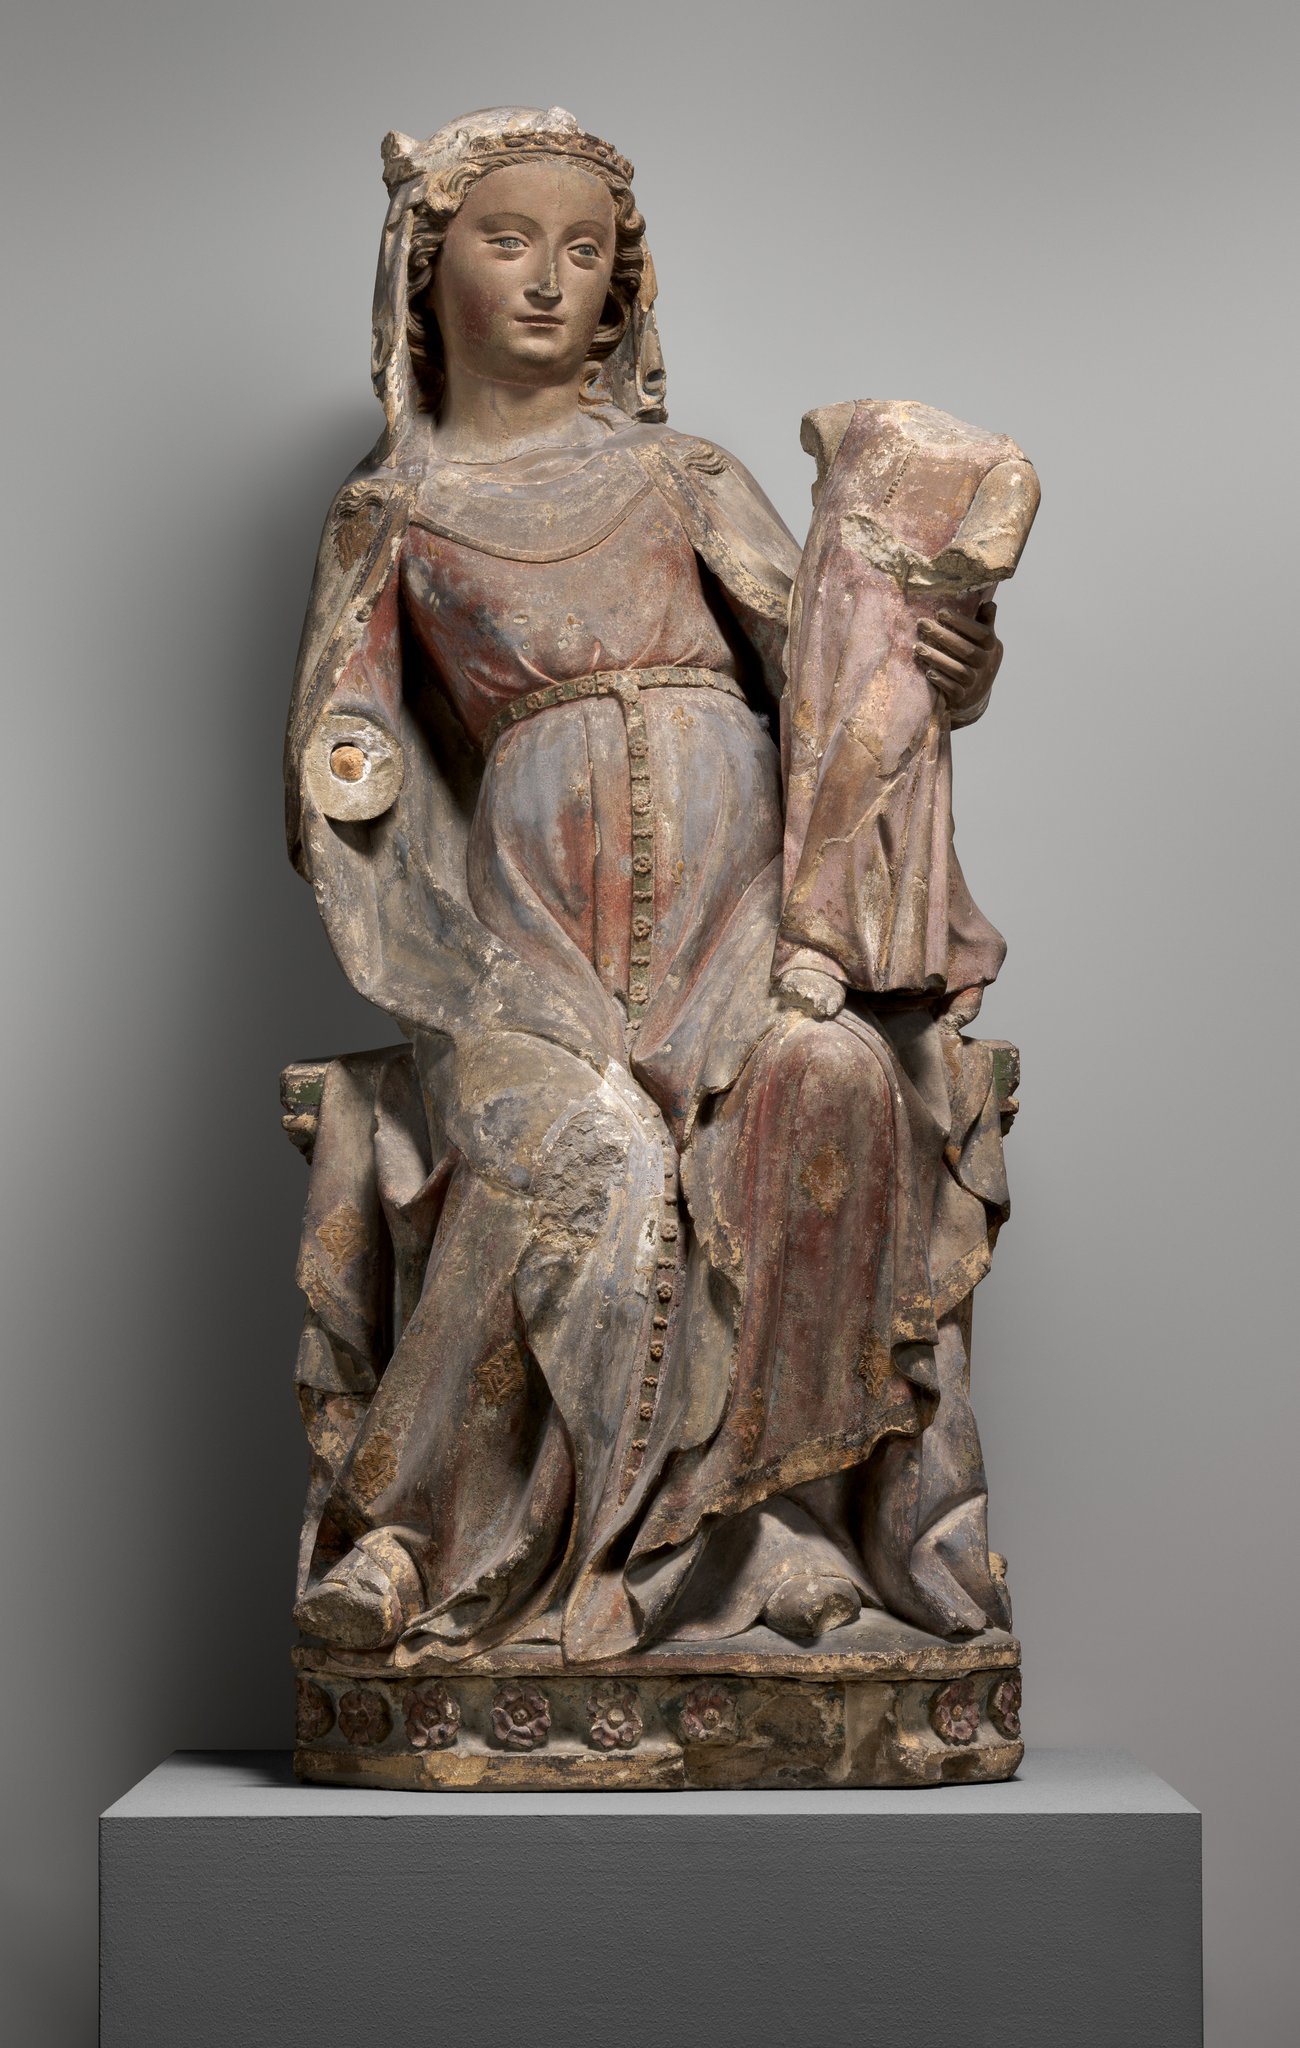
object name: statue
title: Virgin and Child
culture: french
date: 1300-1330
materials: limestone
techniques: polychromy